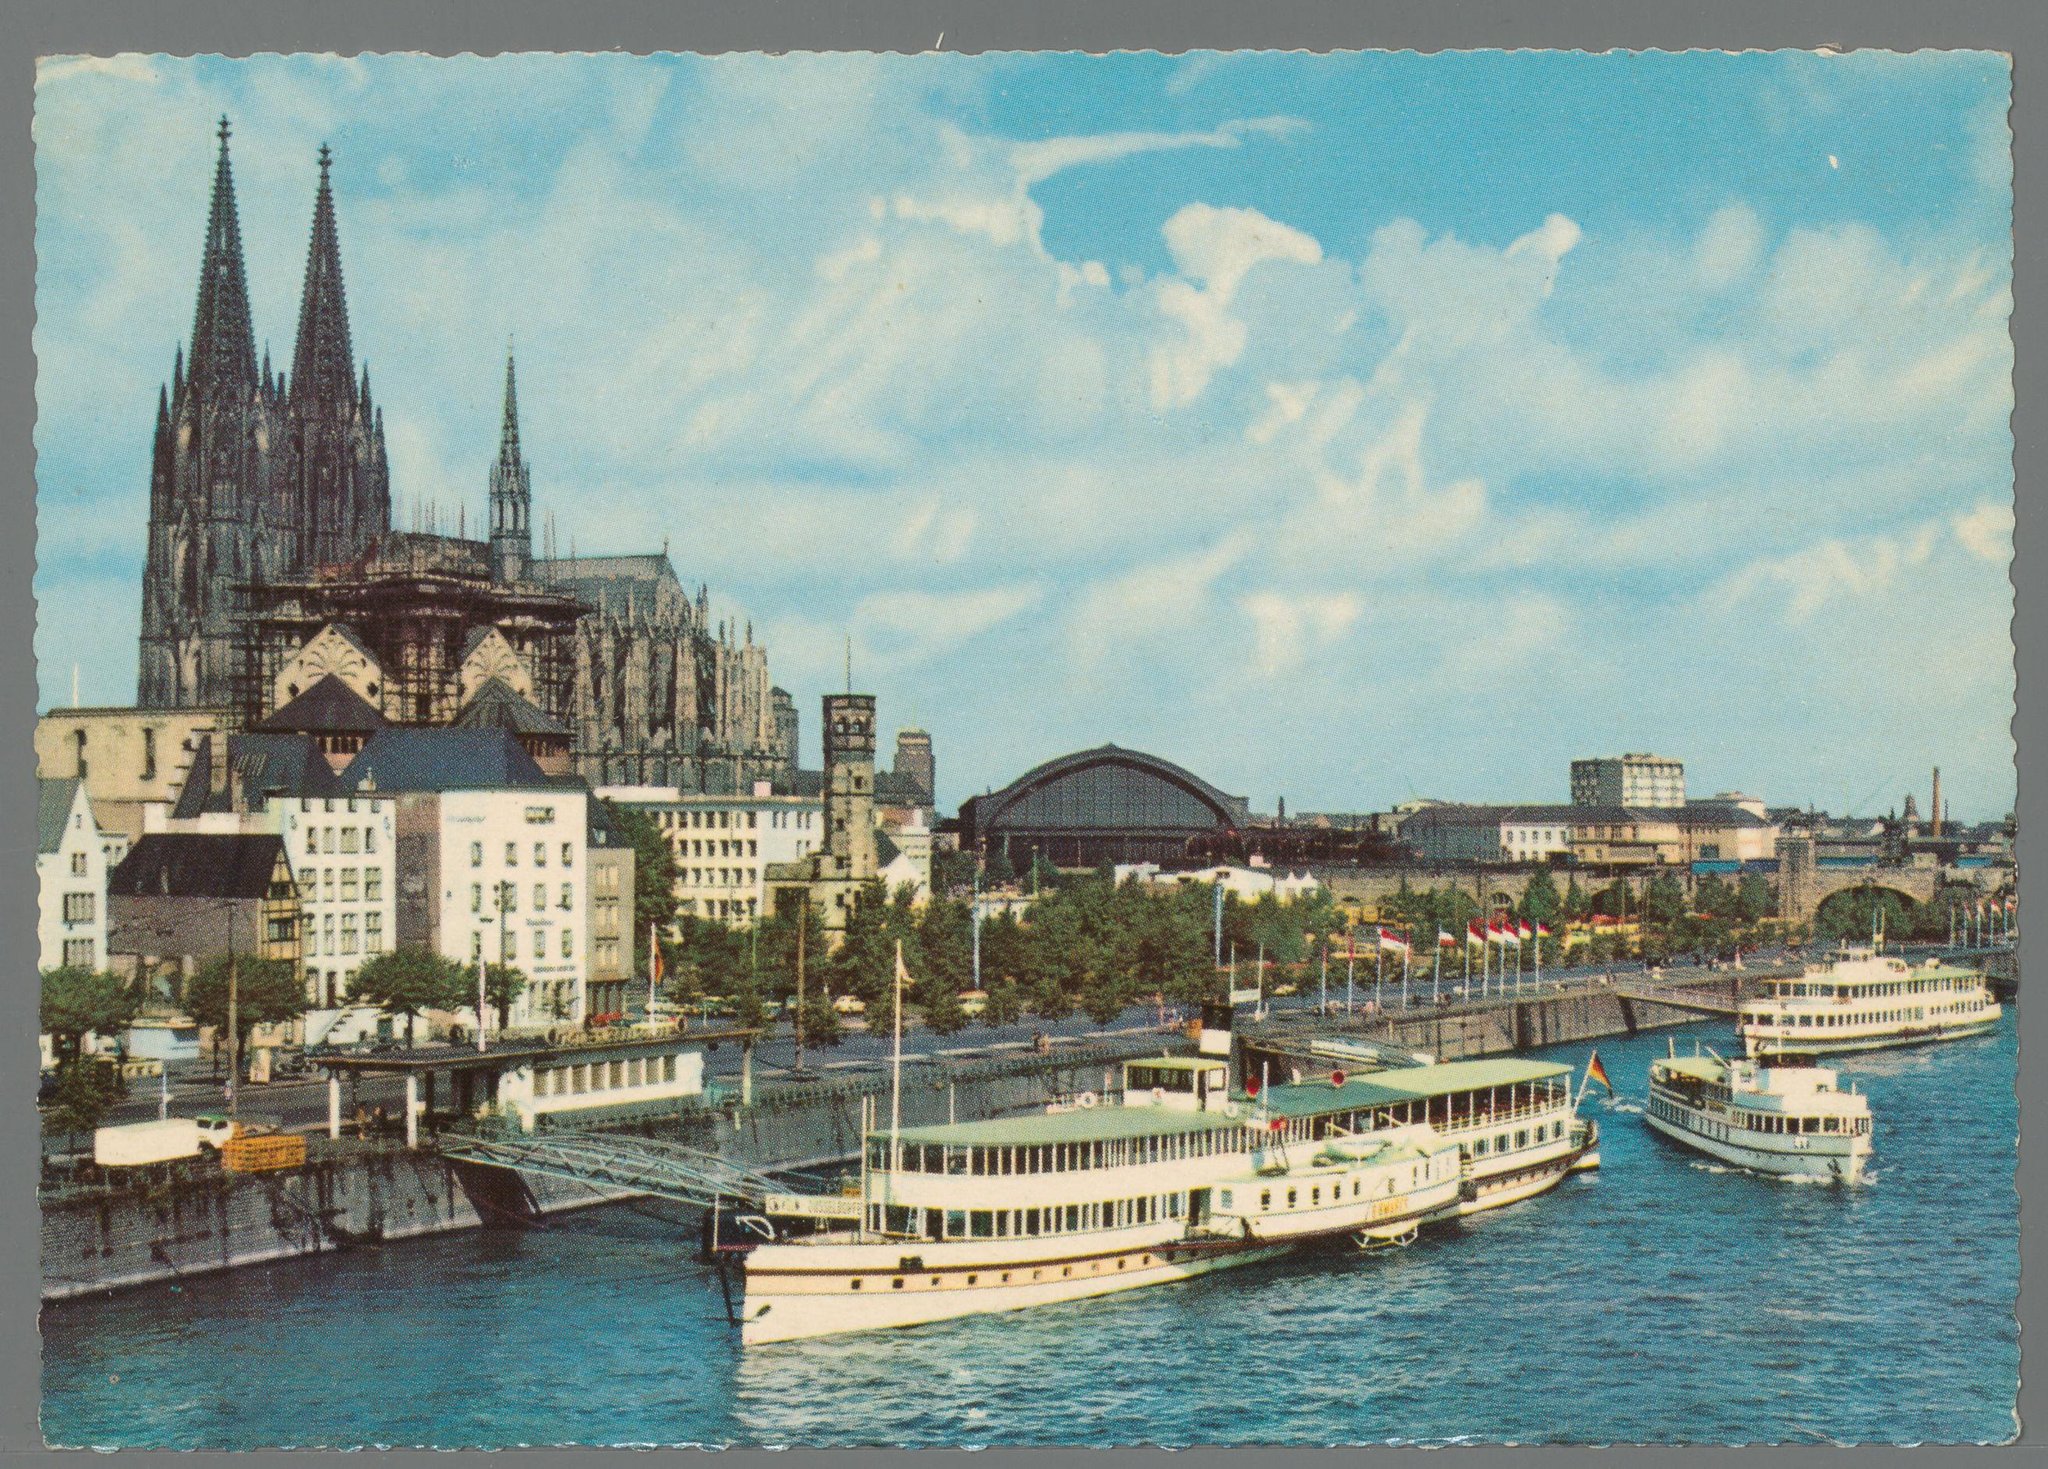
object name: photomechanical print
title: Köln, Dom und Rhein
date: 1960-1989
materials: cardboard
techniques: offset printed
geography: cologne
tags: city-view, and landscape with man-made constructions, church (exterior), canals, waters (in city)